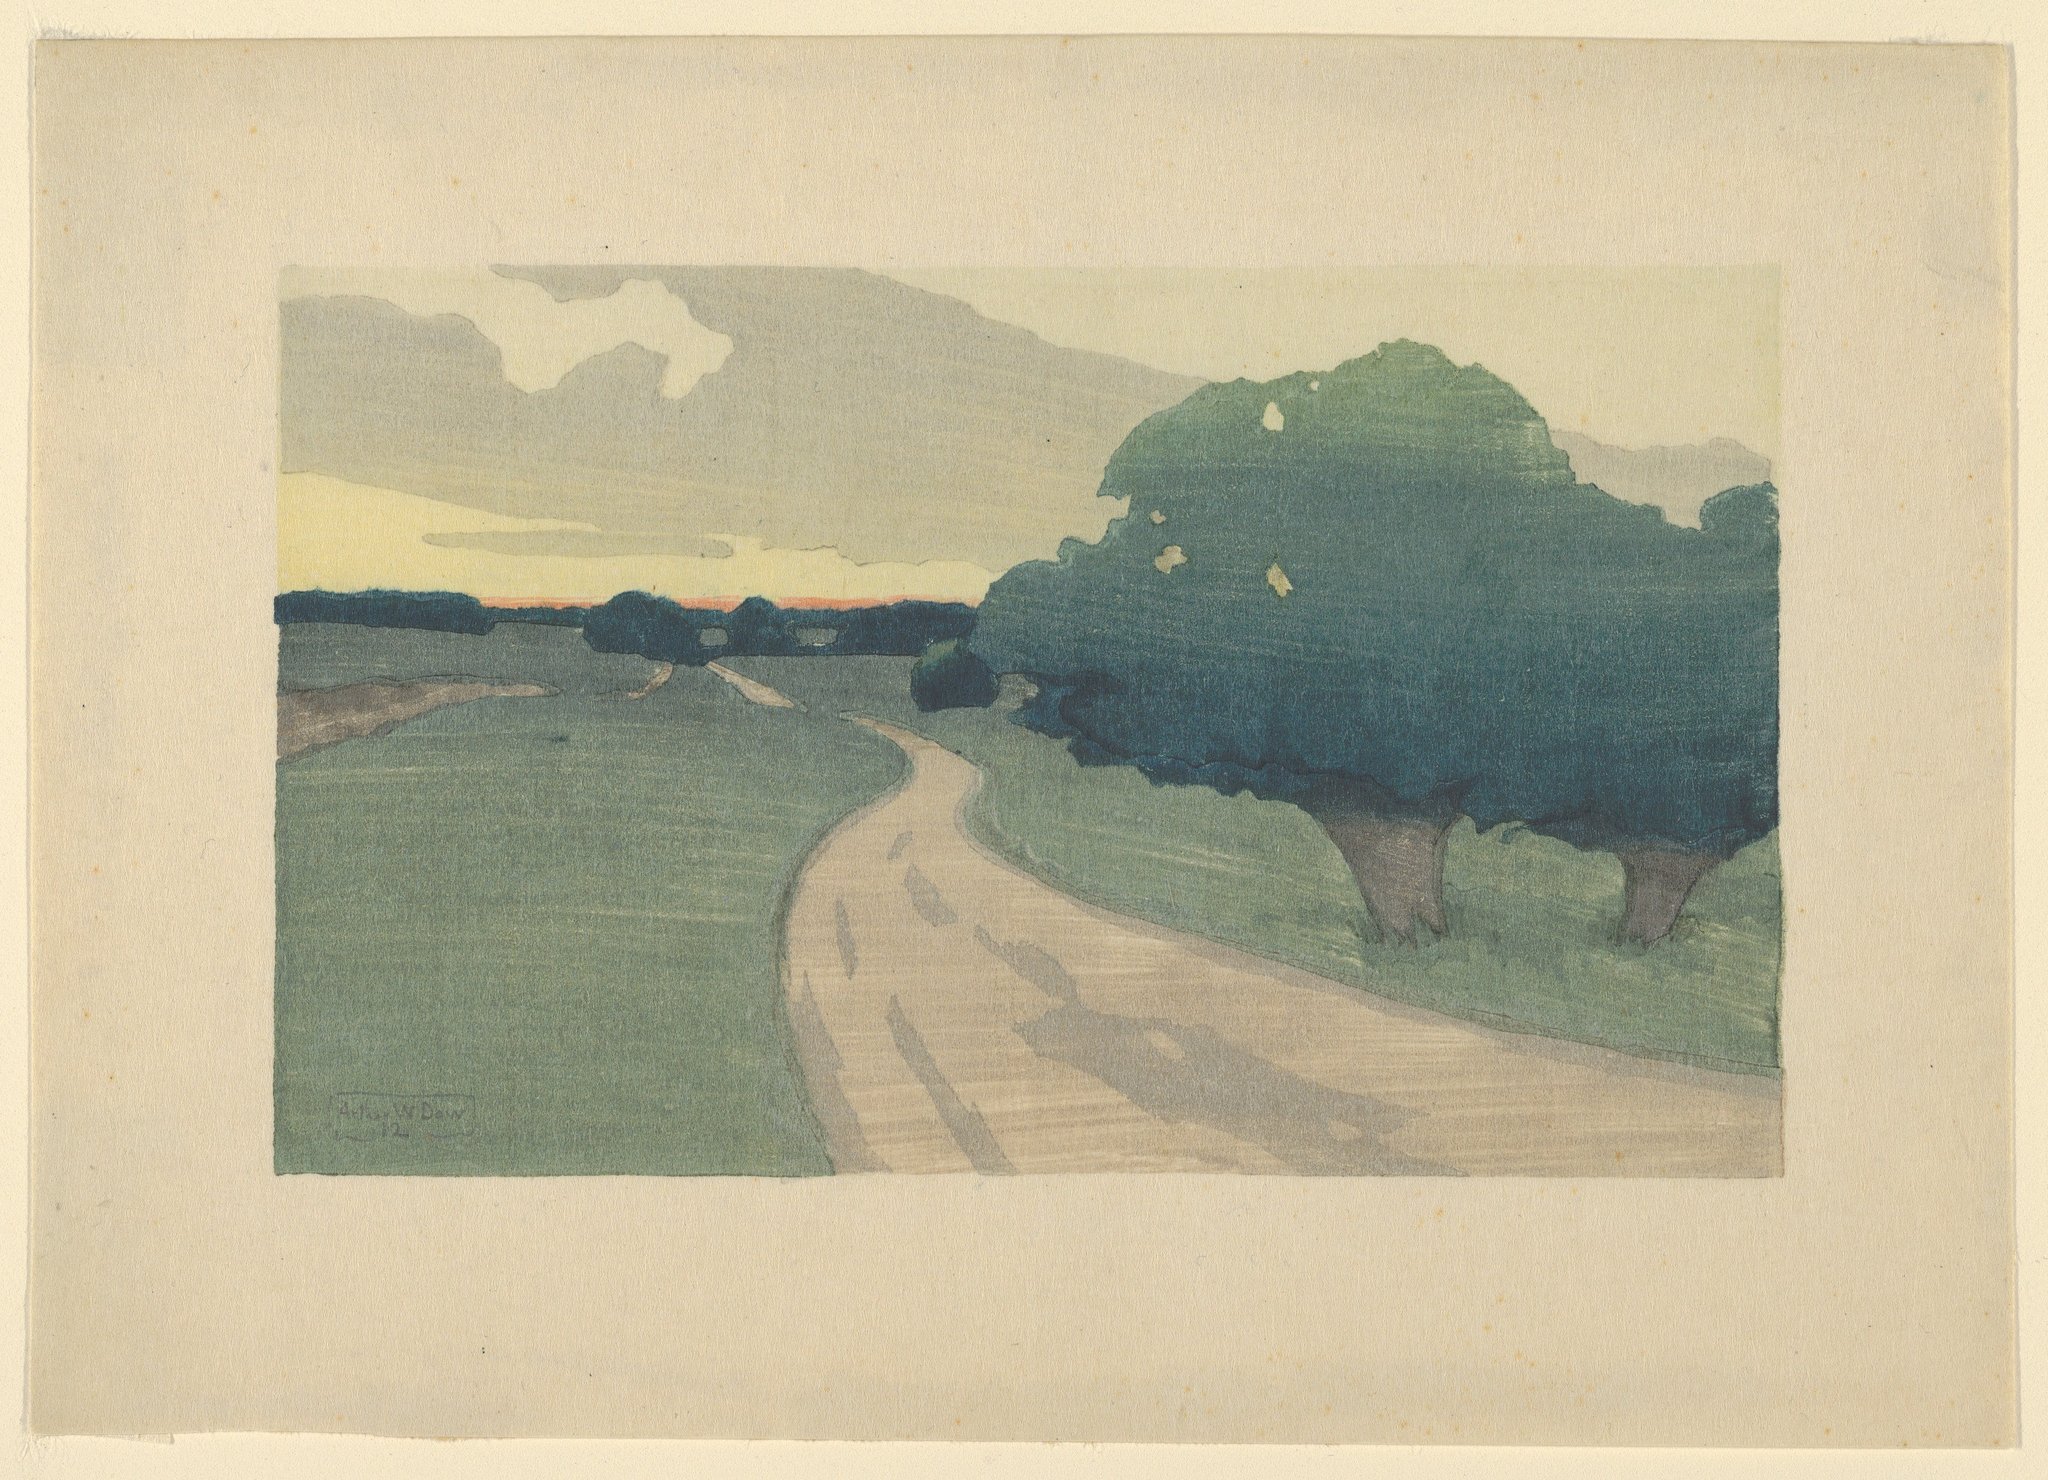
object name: print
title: The Long Road – Argilla Road, Ipswich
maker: arthur wesley dow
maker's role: artist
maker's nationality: american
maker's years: 1857-1922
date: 1898-1912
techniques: woodcut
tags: roads,landscapes,trees